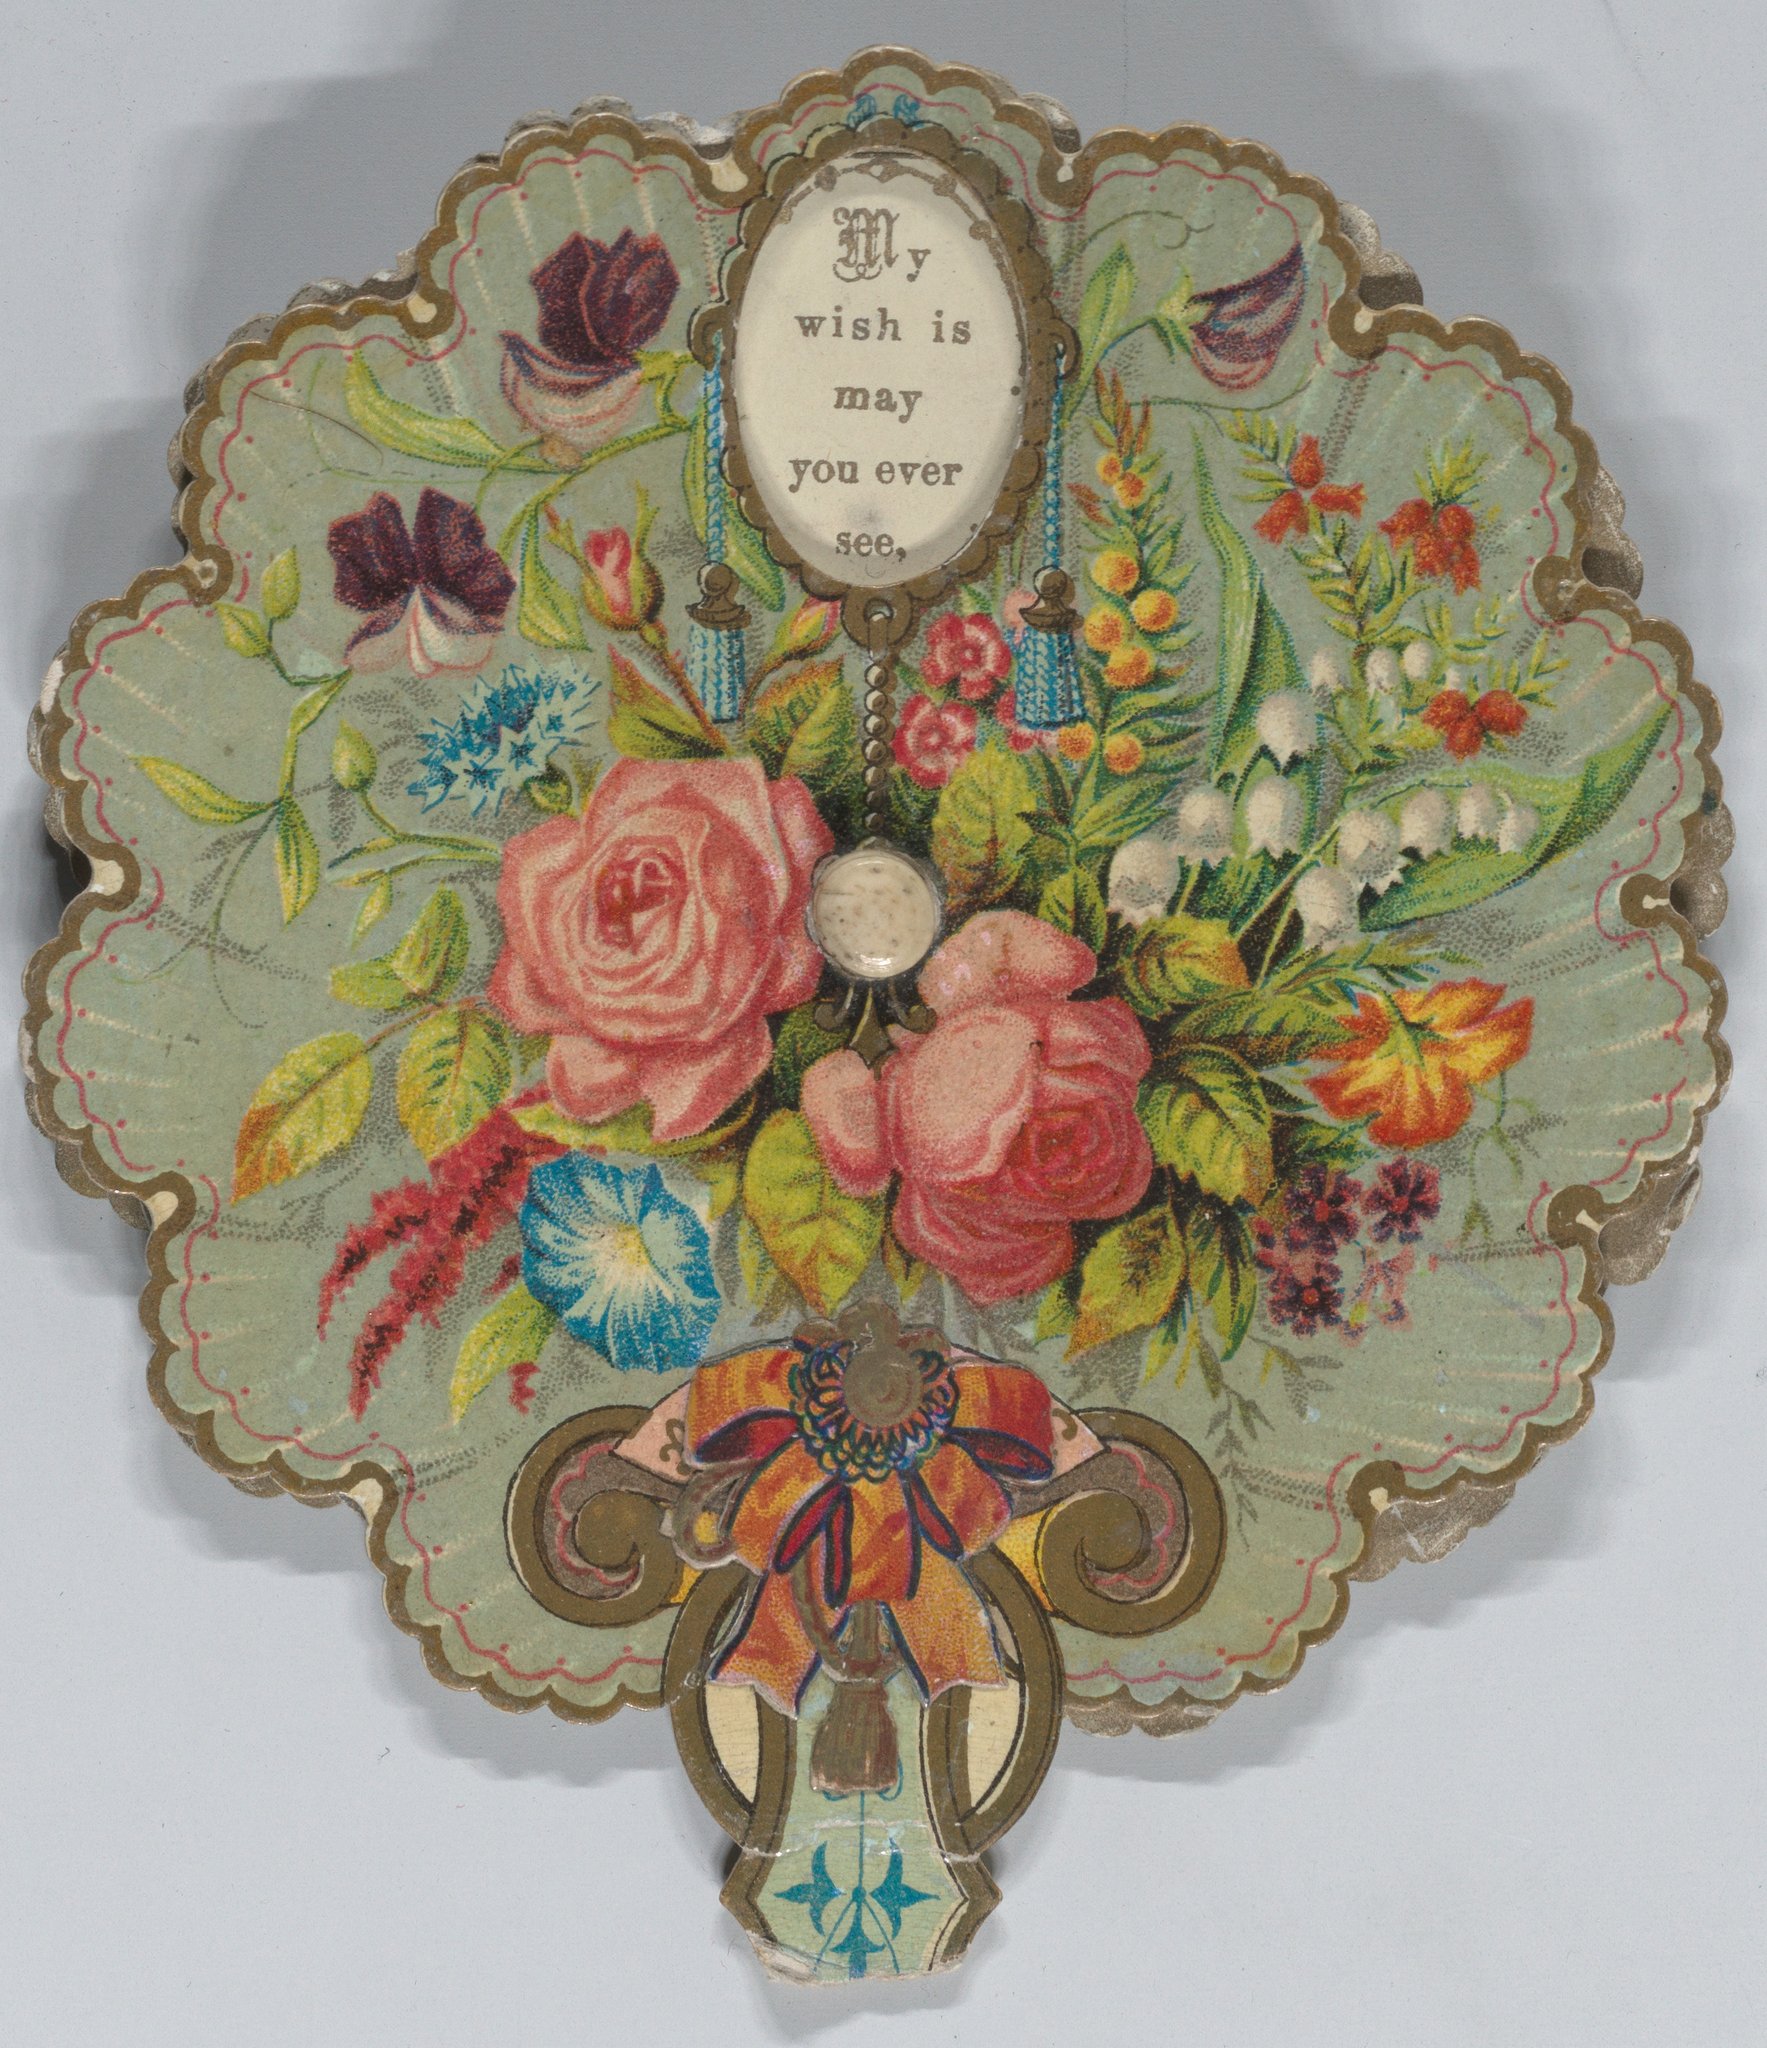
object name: valentine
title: Valentine - Mechanical - Round Birthday bouquet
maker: anonymous, british or american, 19th century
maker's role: artist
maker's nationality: british or american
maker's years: 1800-1900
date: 1875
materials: celluloid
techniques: chromolithography, cutting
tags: flowers